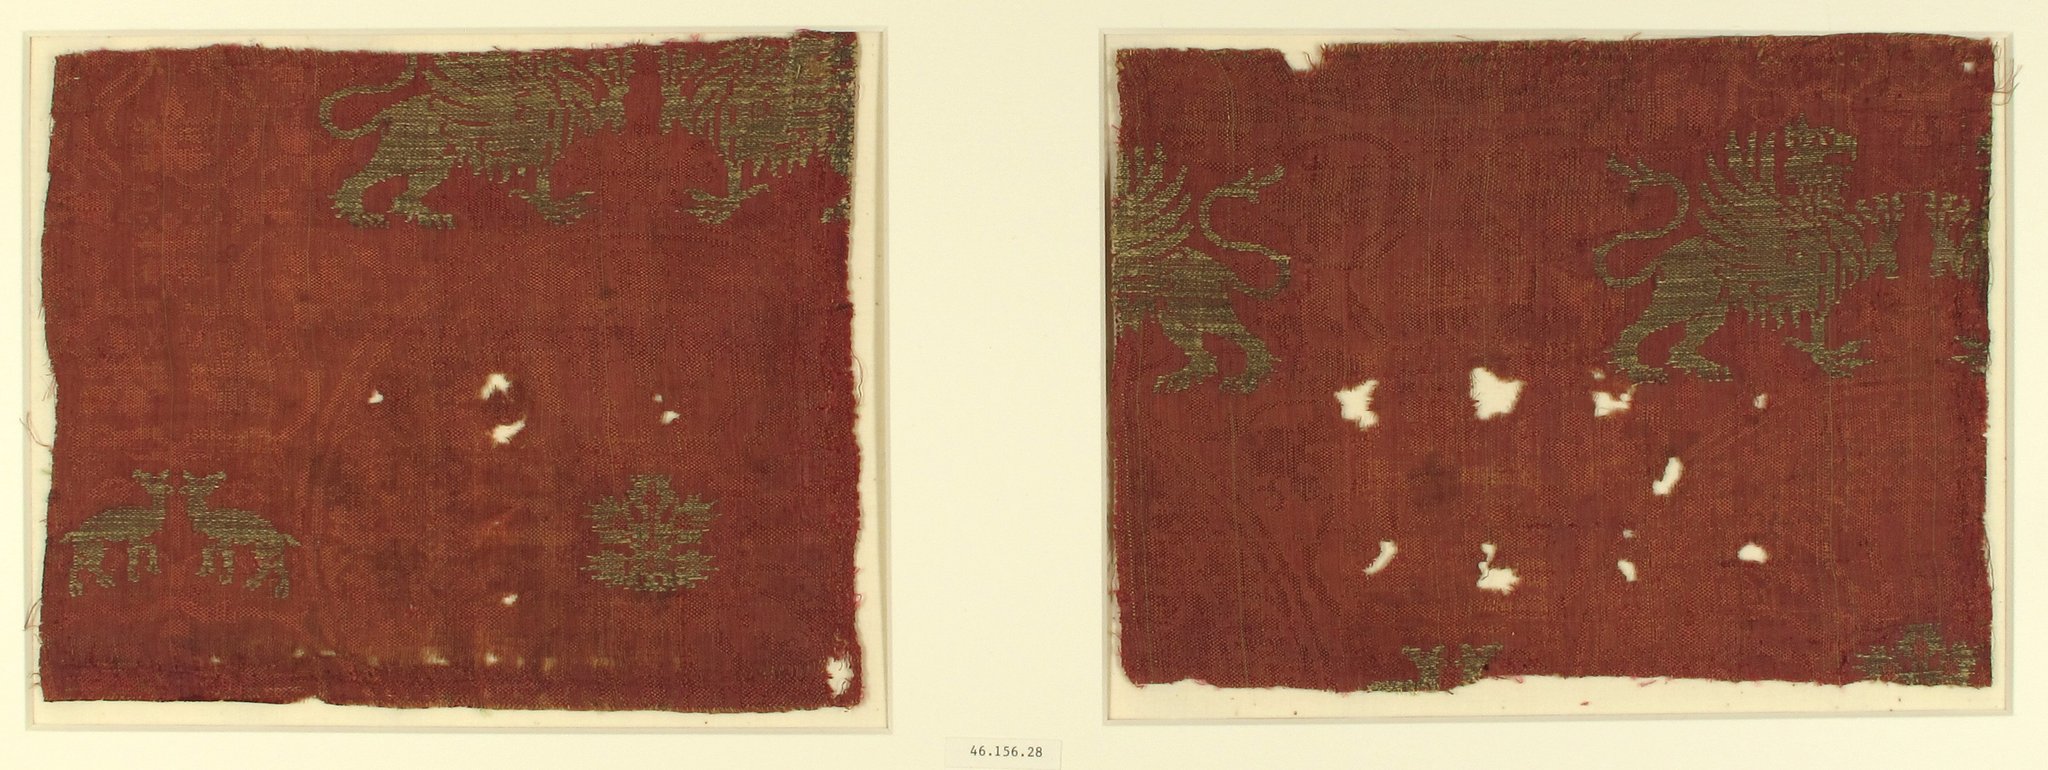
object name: textile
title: Textile with Griffin and Fawn Design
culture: italian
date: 1301-1400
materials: metal thread, silk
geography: italy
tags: griffins,deer